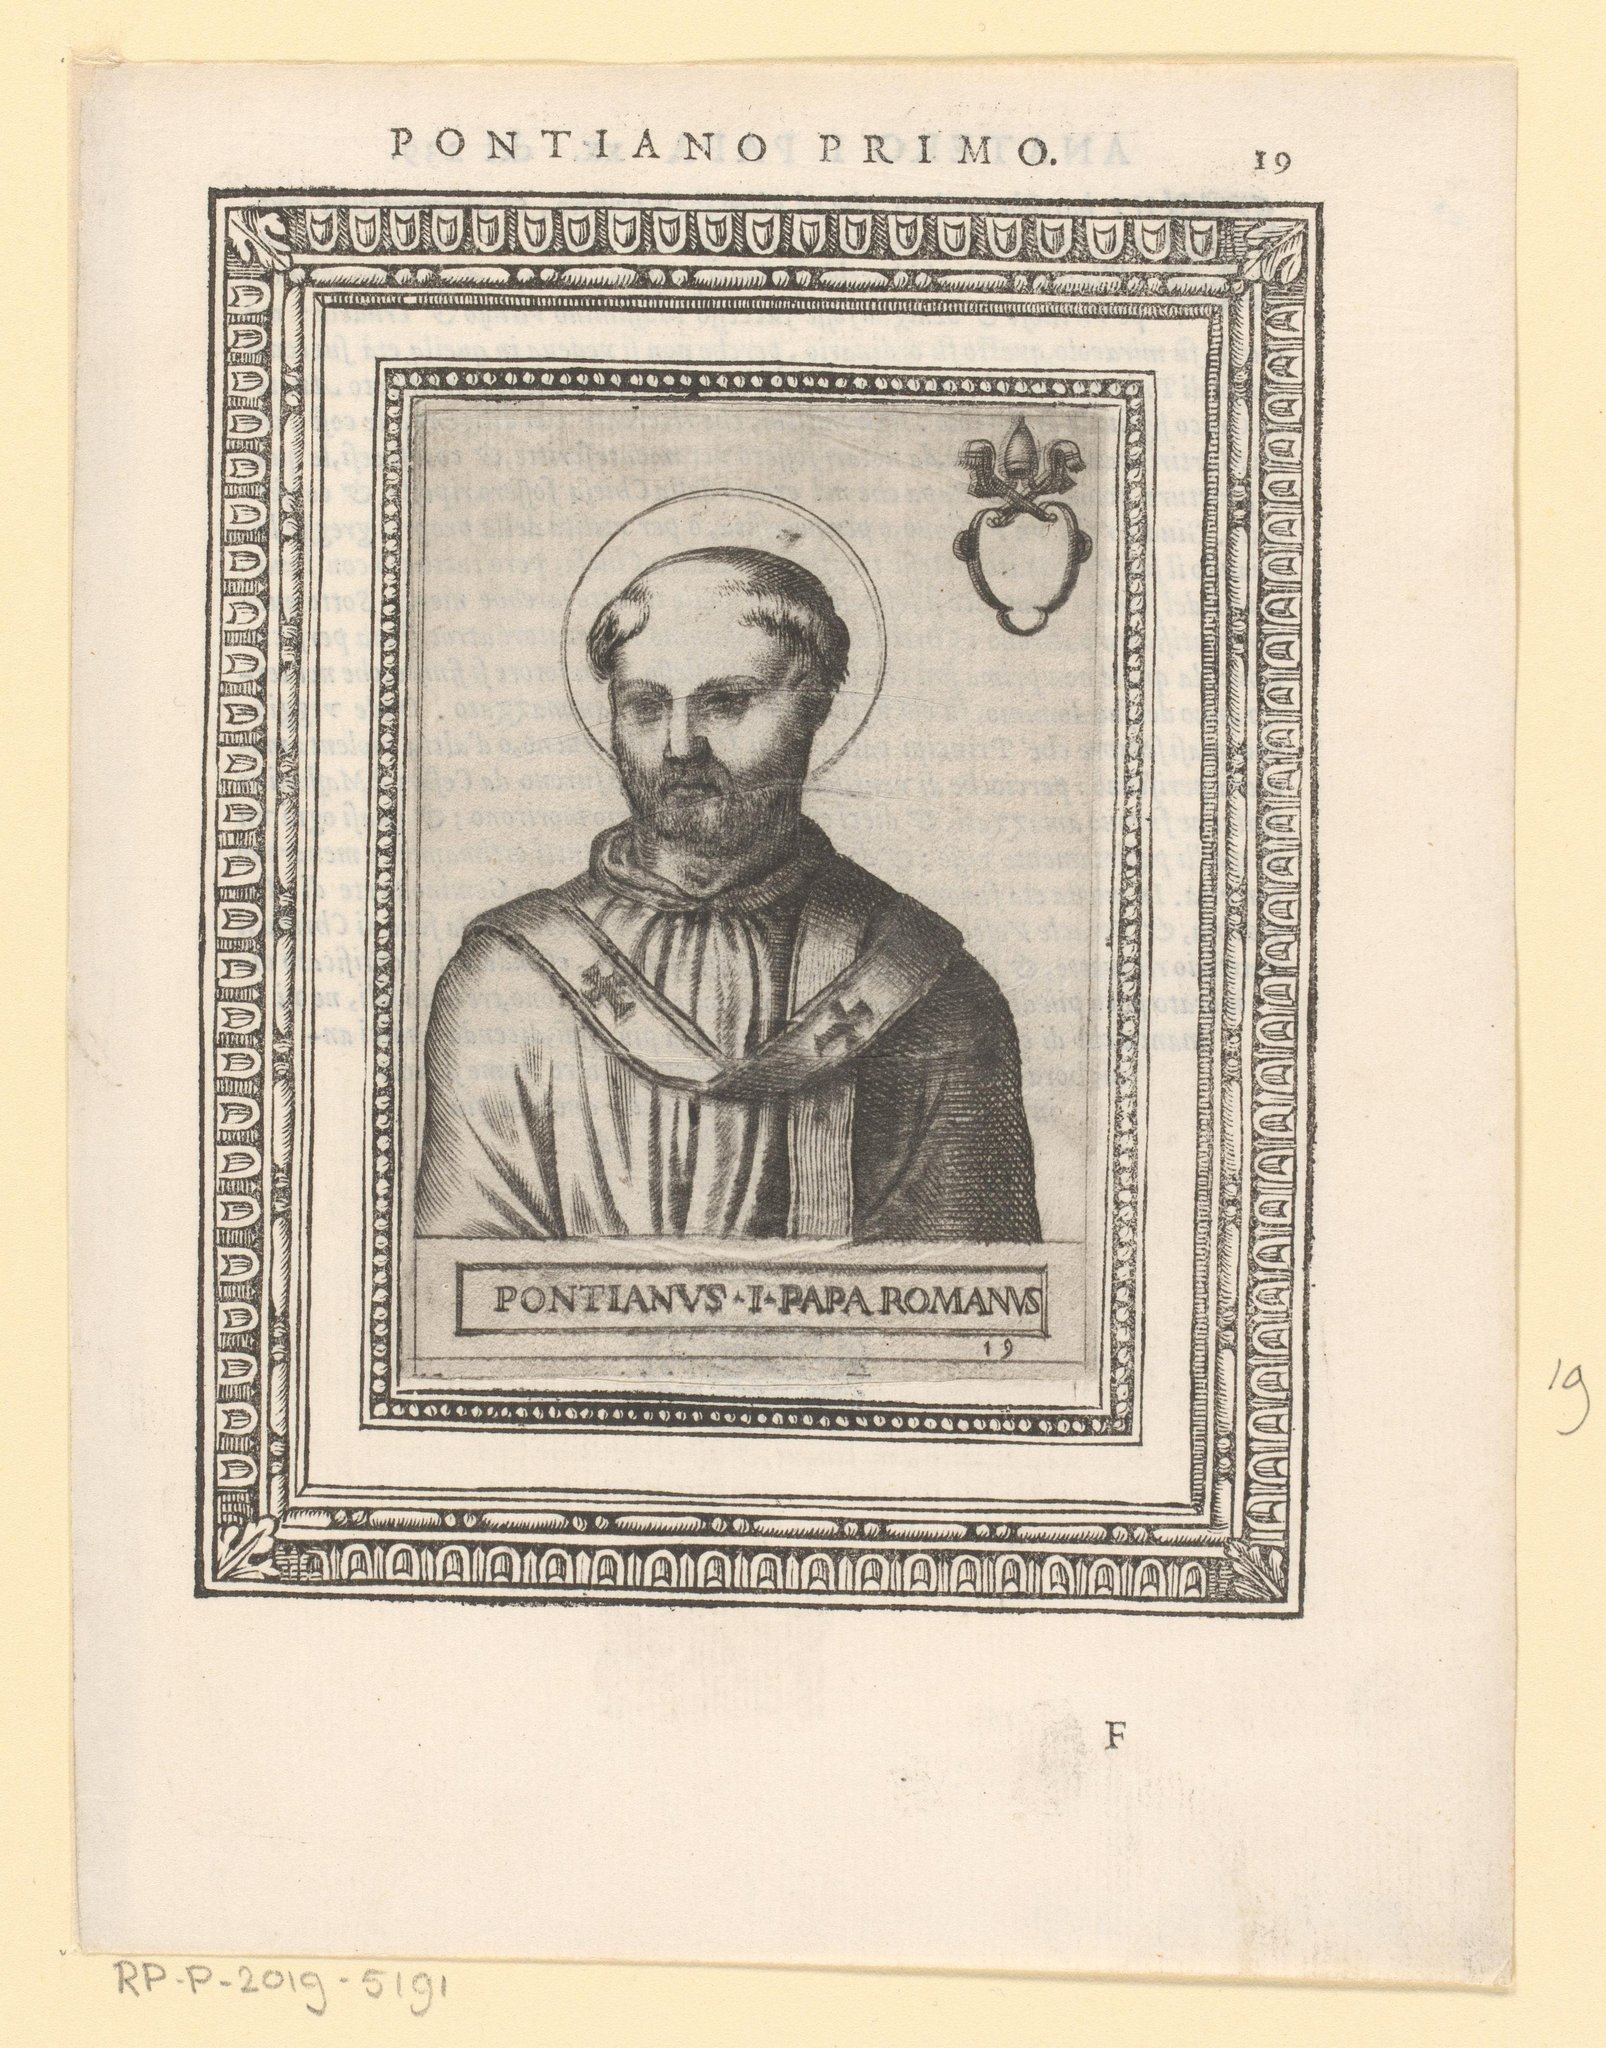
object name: book illustration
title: Portret van paus Pontianus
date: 1587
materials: paper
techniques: engraving, letterpress printing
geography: rome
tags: historical persons, pope, armorial bearing, heraldry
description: Prent uit: Ciccarelli, Antonio. Le vite de Pontefici di Antonio Ciccarelli (...). Rome: Domenico Basa, 1587. Prent voor het eerst verschenen in: Cavalieri, Giovanni Battista de'. Pontificum romanorum effigies (...). Rome: Domenico Basa en Francesco Zanetti, 1580. Prent ook gebruikt in latere publicaties.